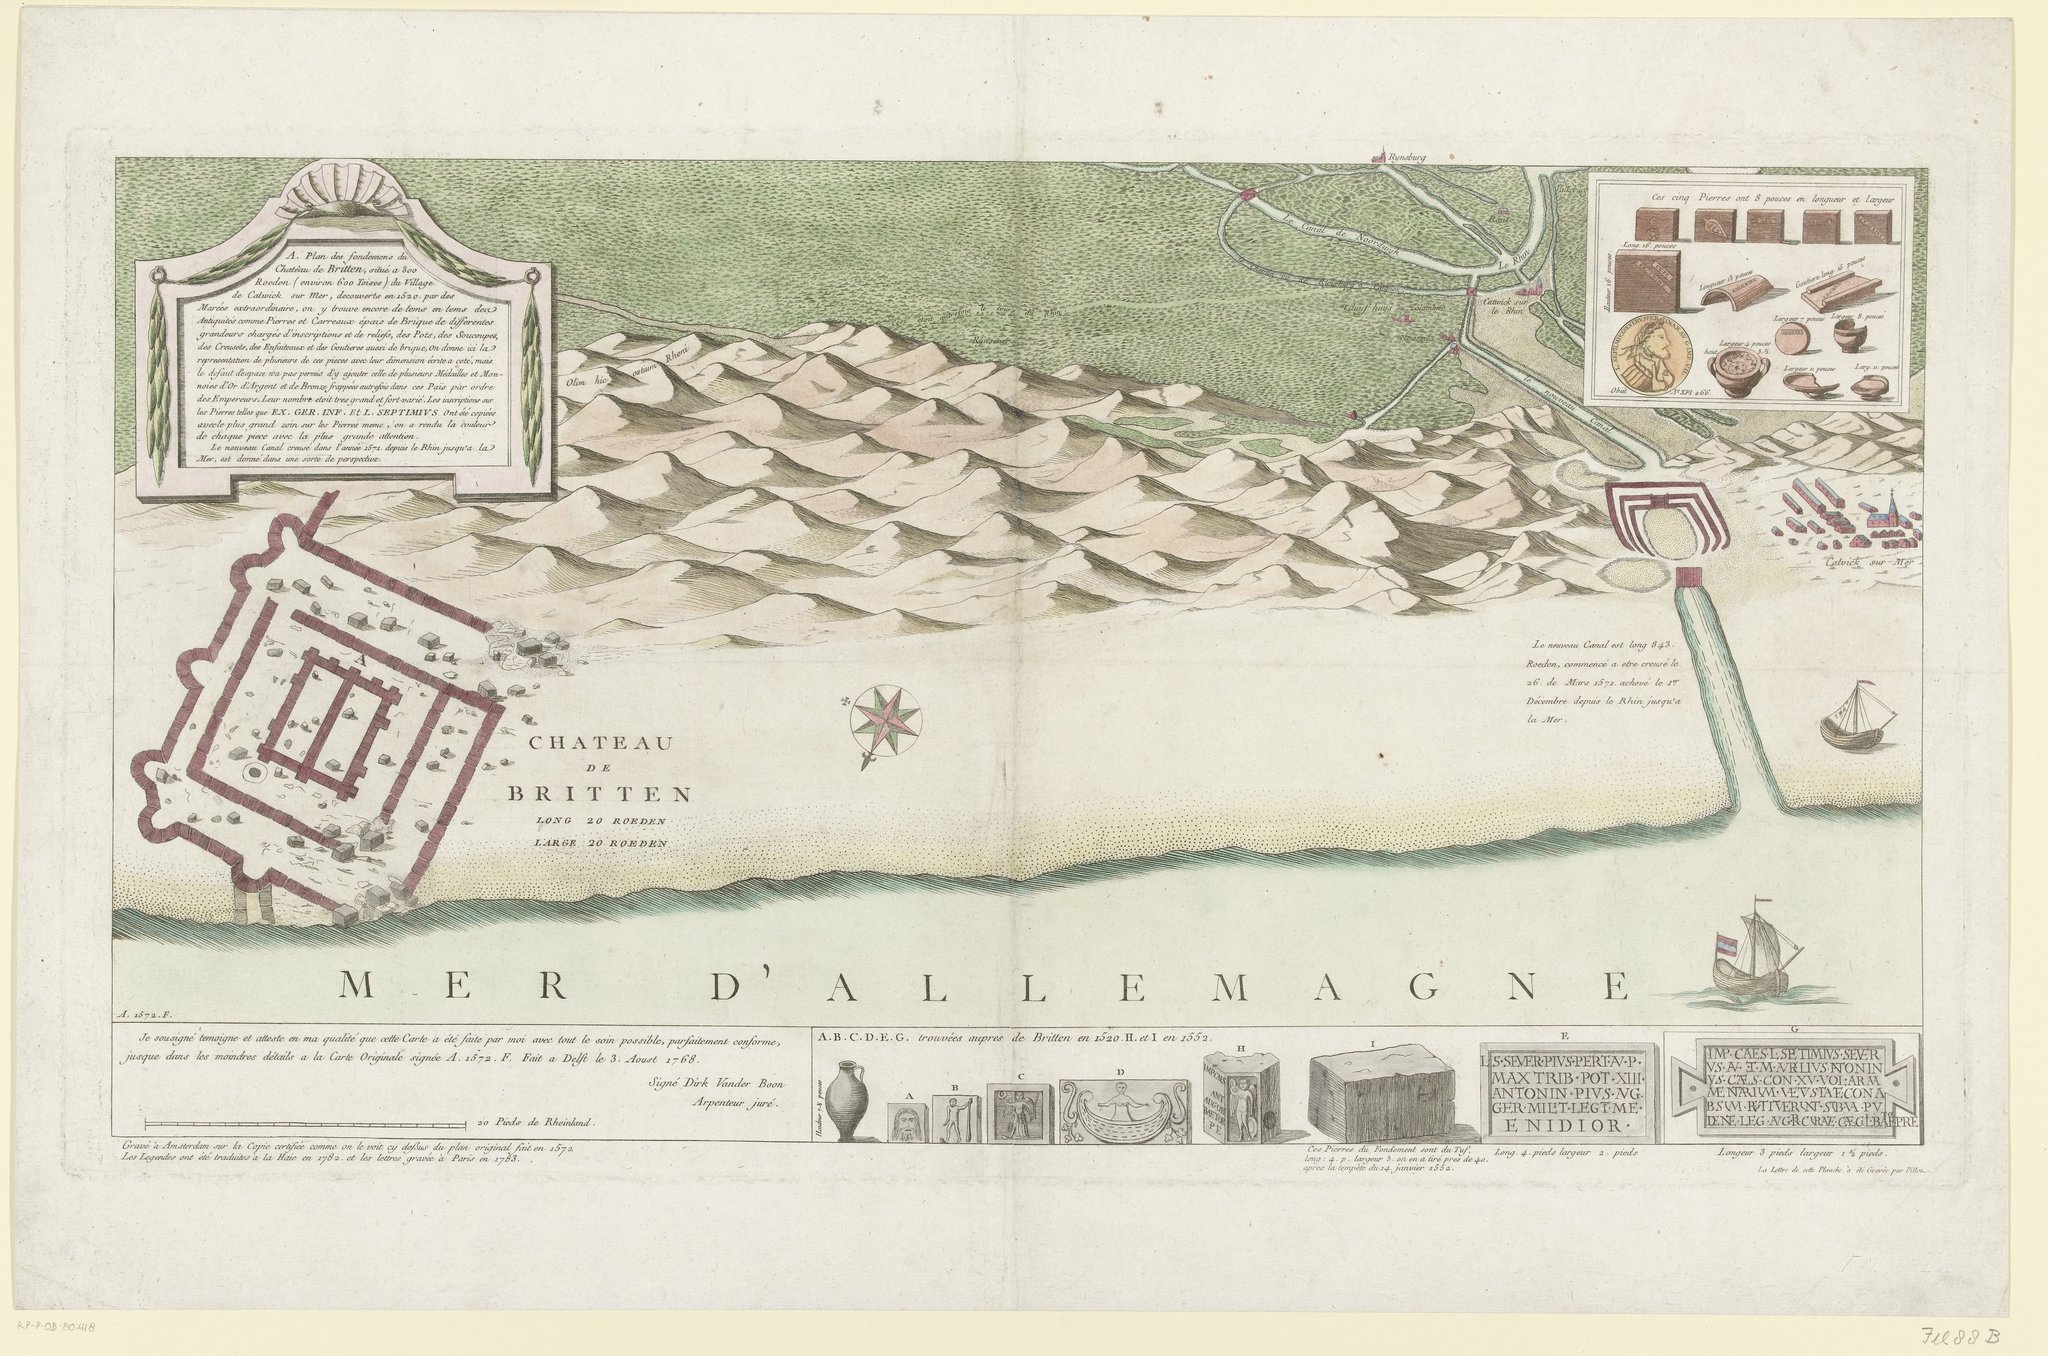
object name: history print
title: Plan van de kust bij Katwijk met de fundamenten van Brittenburg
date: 1783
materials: paper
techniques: engraving, etching, hand coloring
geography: paris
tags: maps of separate countries or regions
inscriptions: date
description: Plan van de kust bij Katwijk aan Zee met de fundamenten van Brittenburg (Huis te Britten). Linksboven een cartouche met een beschrijving van de overblijfselen in het Frans. Rechts en onderaan een overzicht van ter plekke gevonden oudheden. Vervaardigd naar een oude anonieme tekening uit 1572 waarvan de juistheid wordt gecertificeerd door landmeter Dirk van der Boon.